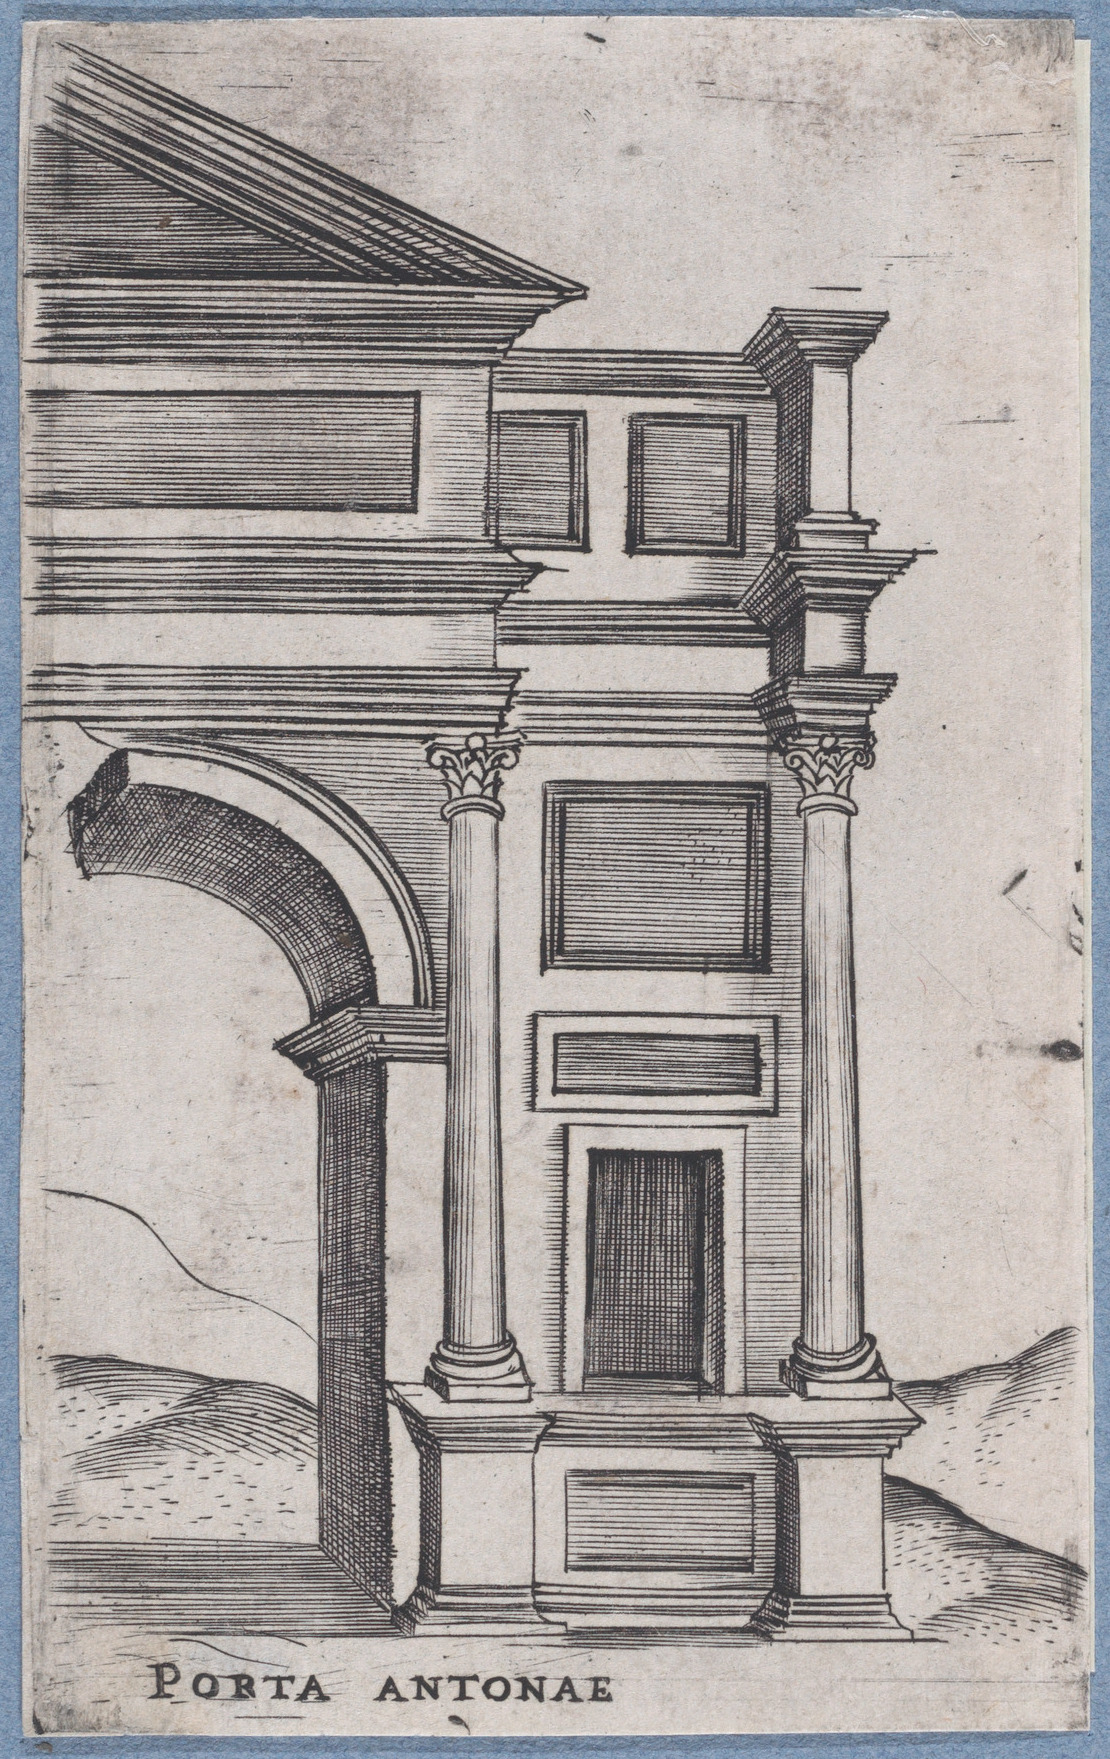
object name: print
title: Porta Antonae, from "Views of Ancient Roman Temples and Arches"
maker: anonymous, italian, 16th century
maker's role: artist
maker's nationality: italian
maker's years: 1500-1600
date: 1535-1540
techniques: engraving